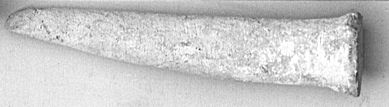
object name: cone, uninscribed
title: Funerary Cone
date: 2124-1981 BCE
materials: paint, pottery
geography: egypt